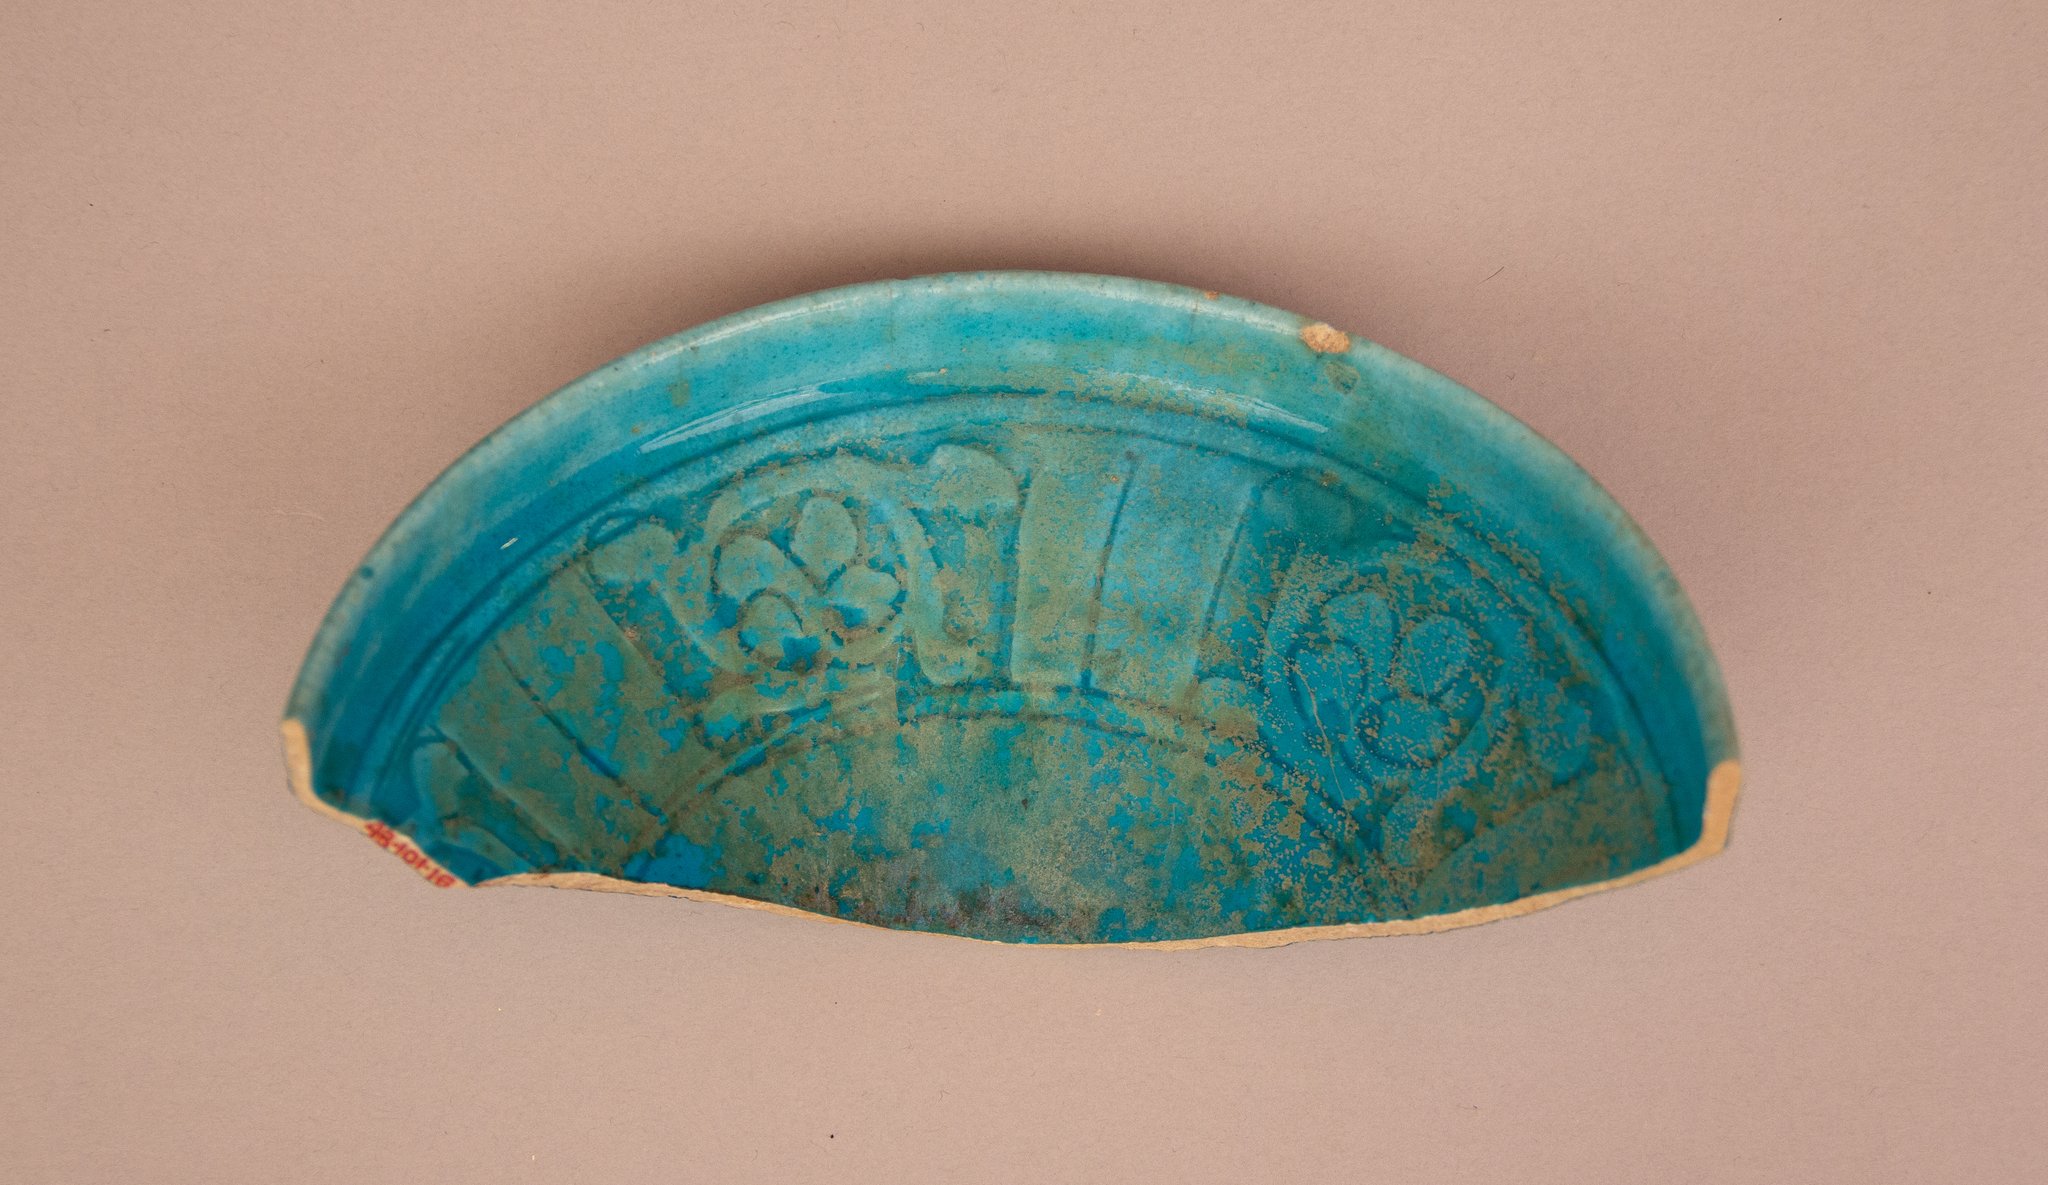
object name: fragment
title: Fragment of Bowl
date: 701-1200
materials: earthenware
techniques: carving, glazing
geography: iran